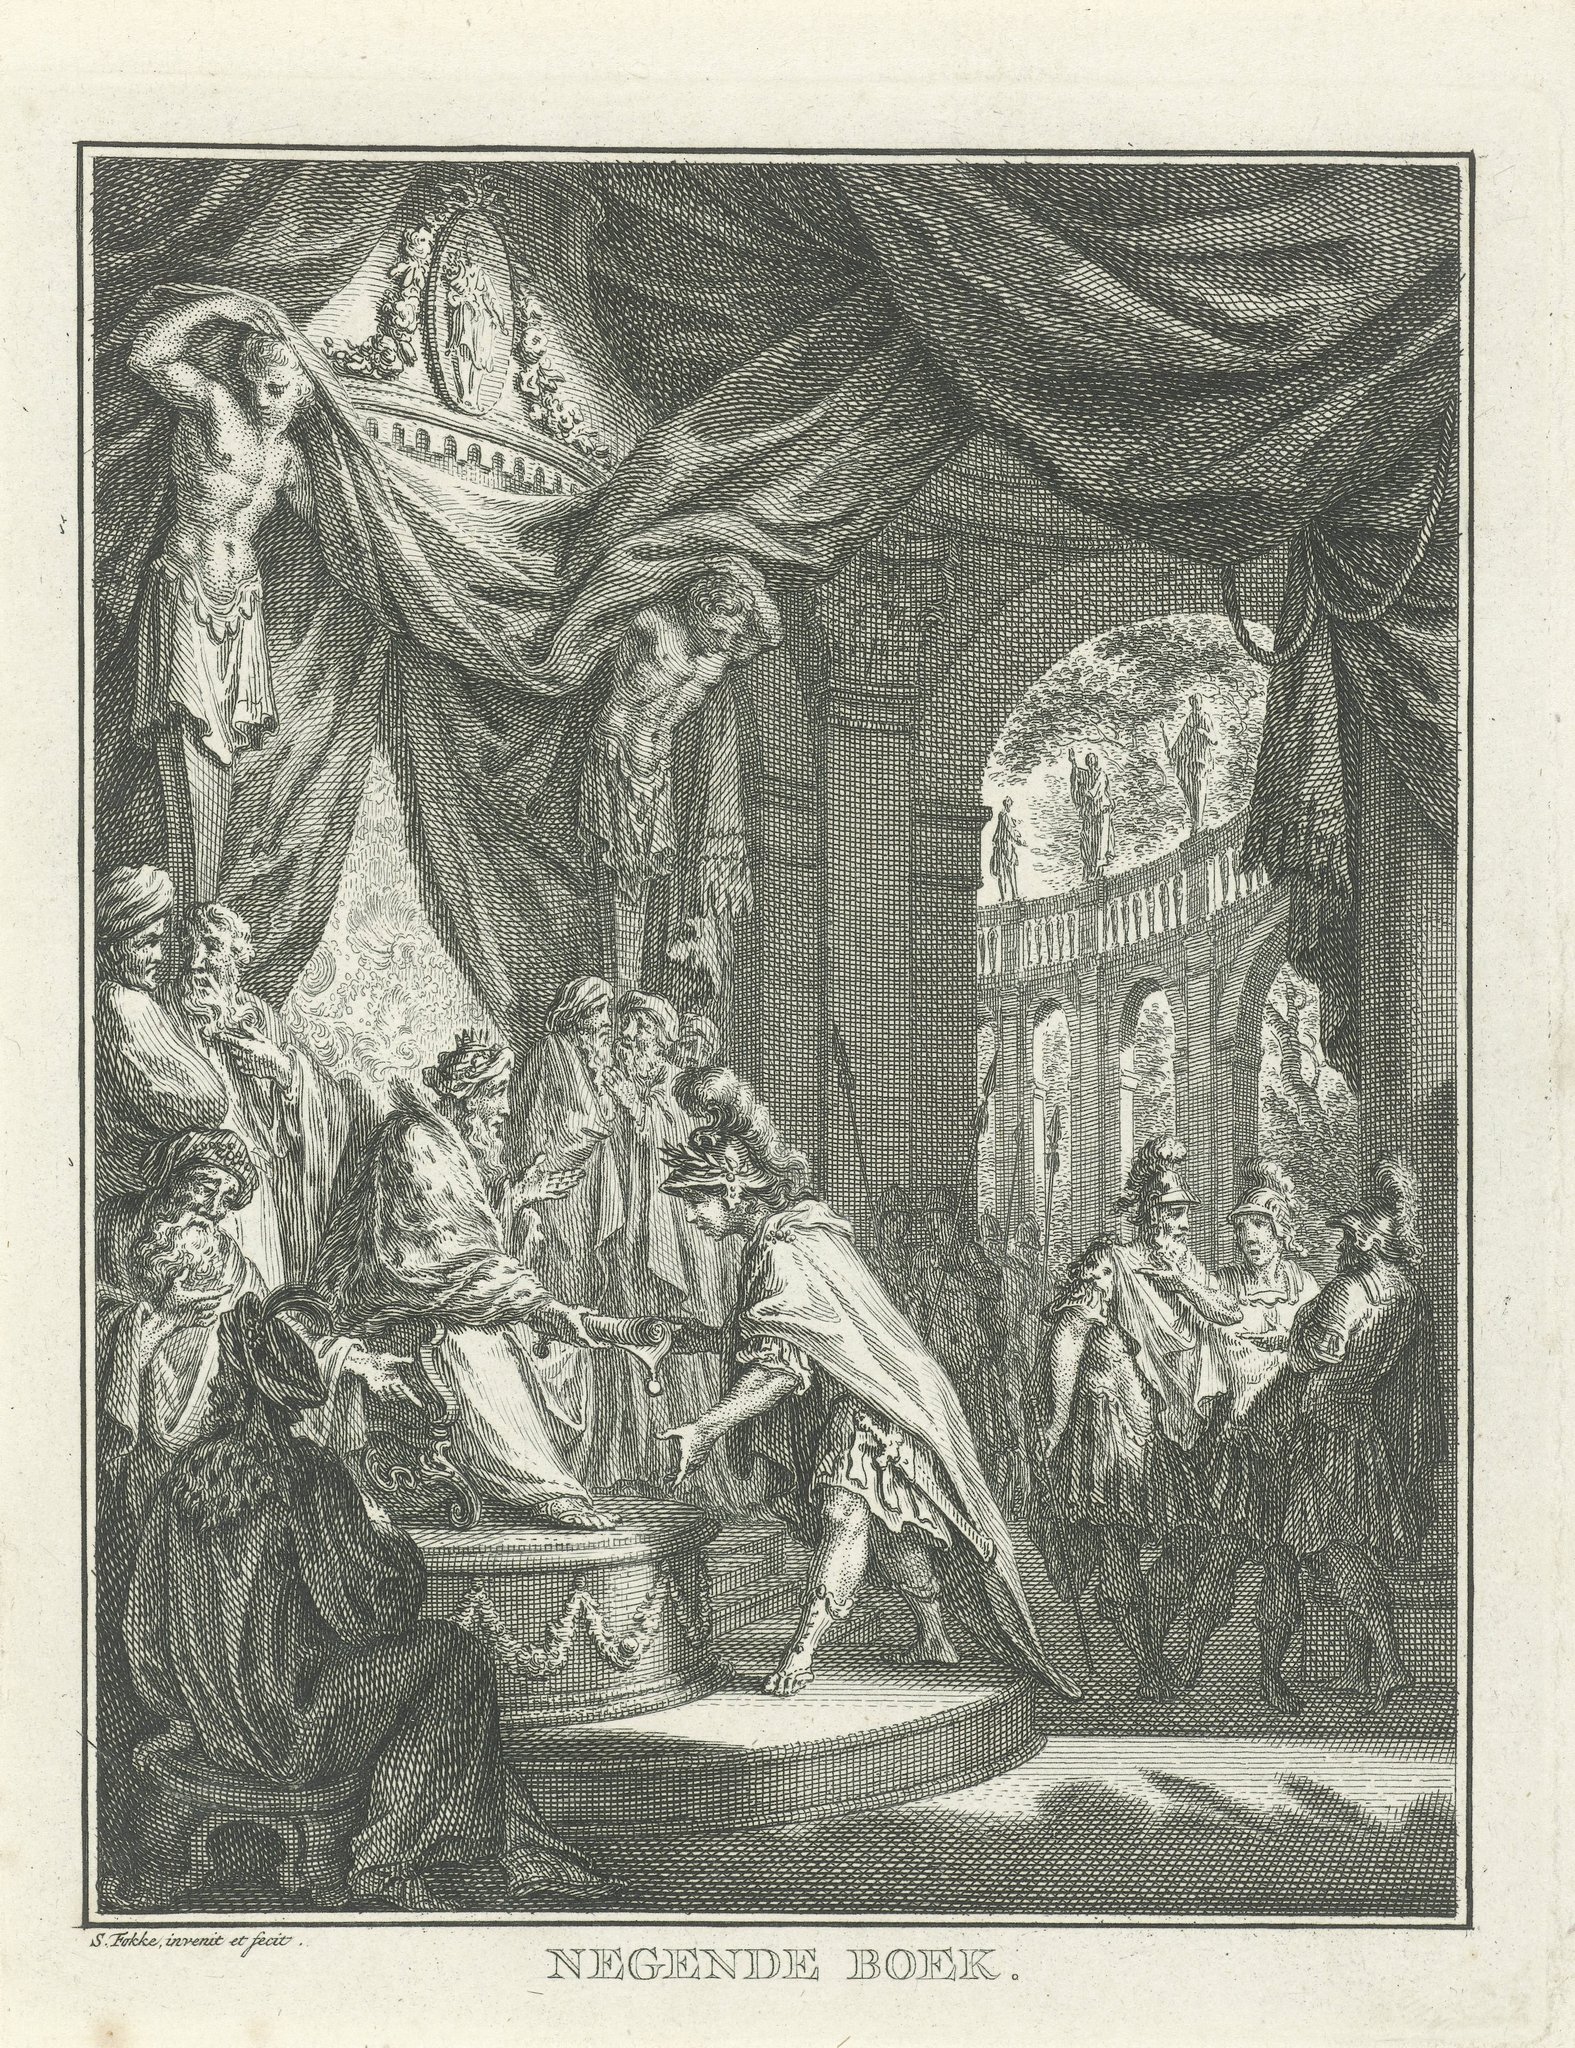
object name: print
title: Negende Boek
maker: simon fokke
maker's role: draughtsman, print maker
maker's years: 1712-1784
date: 1766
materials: paper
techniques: etching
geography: amsterdam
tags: david appointed life-guard of achish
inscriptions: collector's mark: Lugt 2228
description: De op een troon gezeten koning Achis overhandigt David een opgerold document waarmee David wordt aangesteld als zijn vaste lijfwacht. Rond de troon staan dienaren en soldaten van de koning met elkaar te praten en wijzen daarbij naar het tweetal. De prent maakt deel uit van een serie over het verhaal van David en Saul.